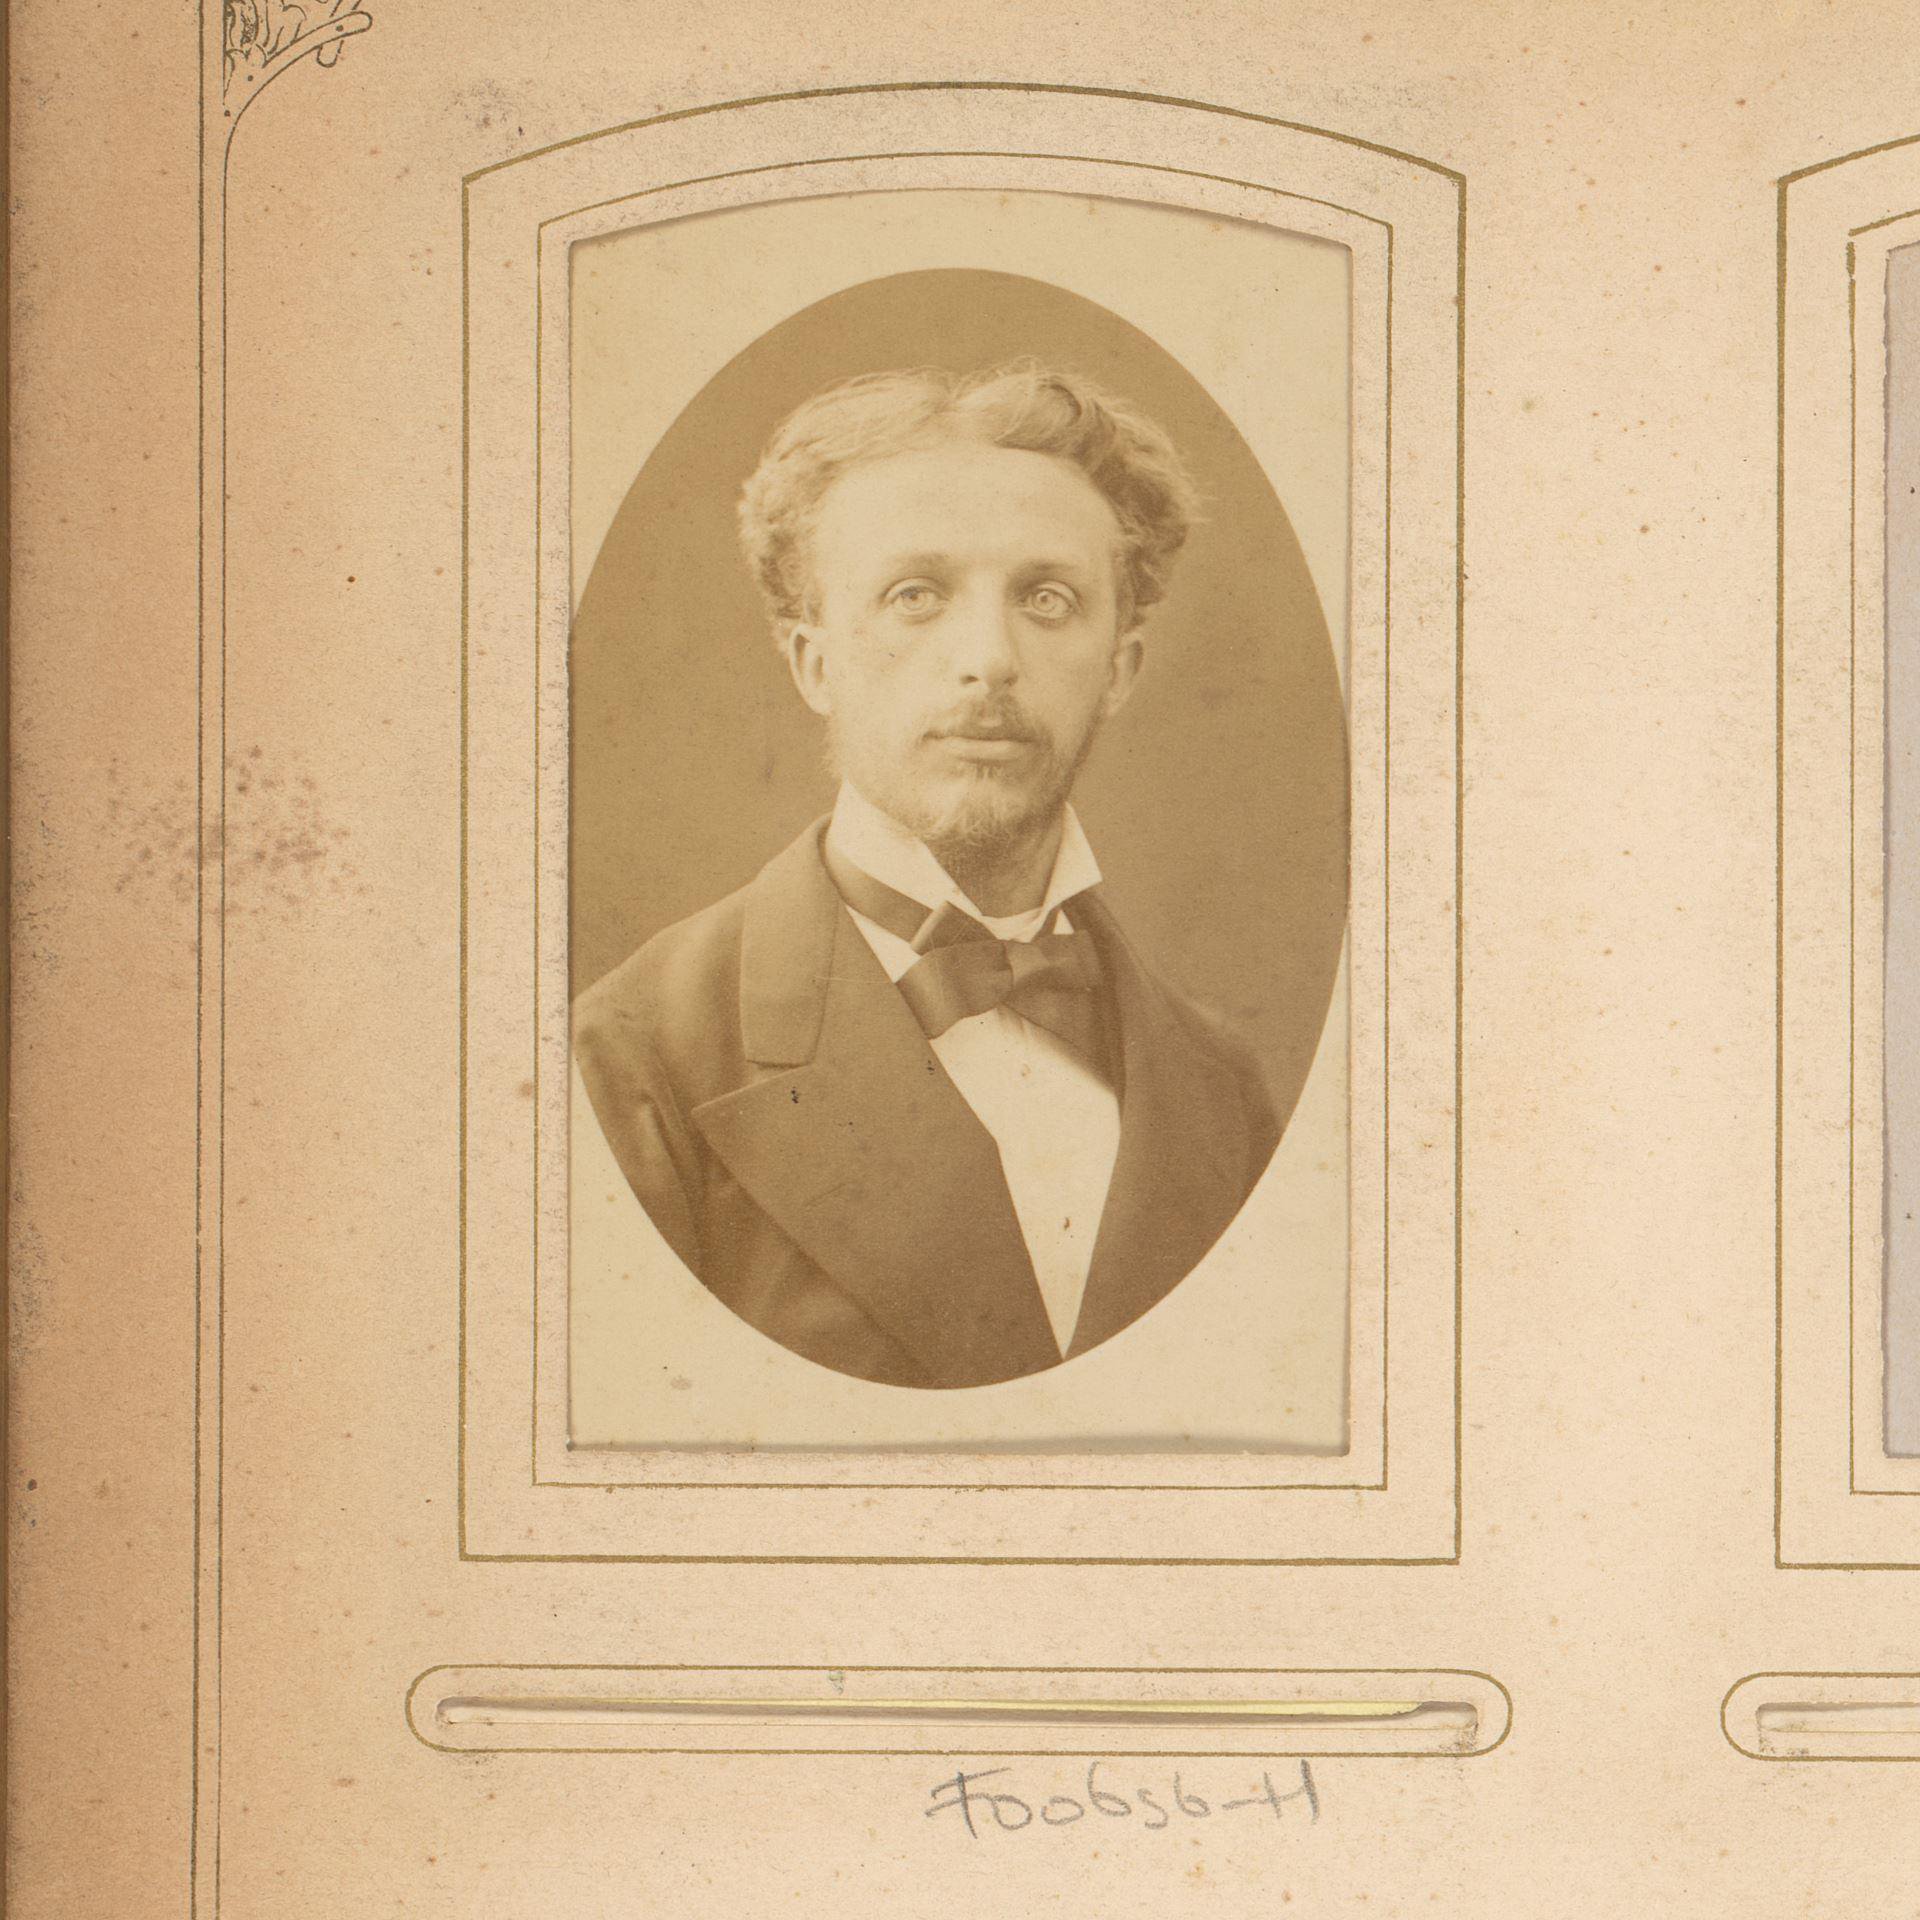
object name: carte de visite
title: Portret van een man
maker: armand dandoy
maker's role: painter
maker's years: 1834-1898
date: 1856-1898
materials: cardboard, photographic support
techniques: albumen print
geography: namur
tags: historical persons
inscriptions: inscription: ‘Ar. DANDOY/ PHOTOGR./ BREVETÉ/ 6, RUE DE LA STATION, 6/ NAMUR/ Spécialité de Photographies/ Inaltérable au Charbon/ Les Clichés sont conservés.’